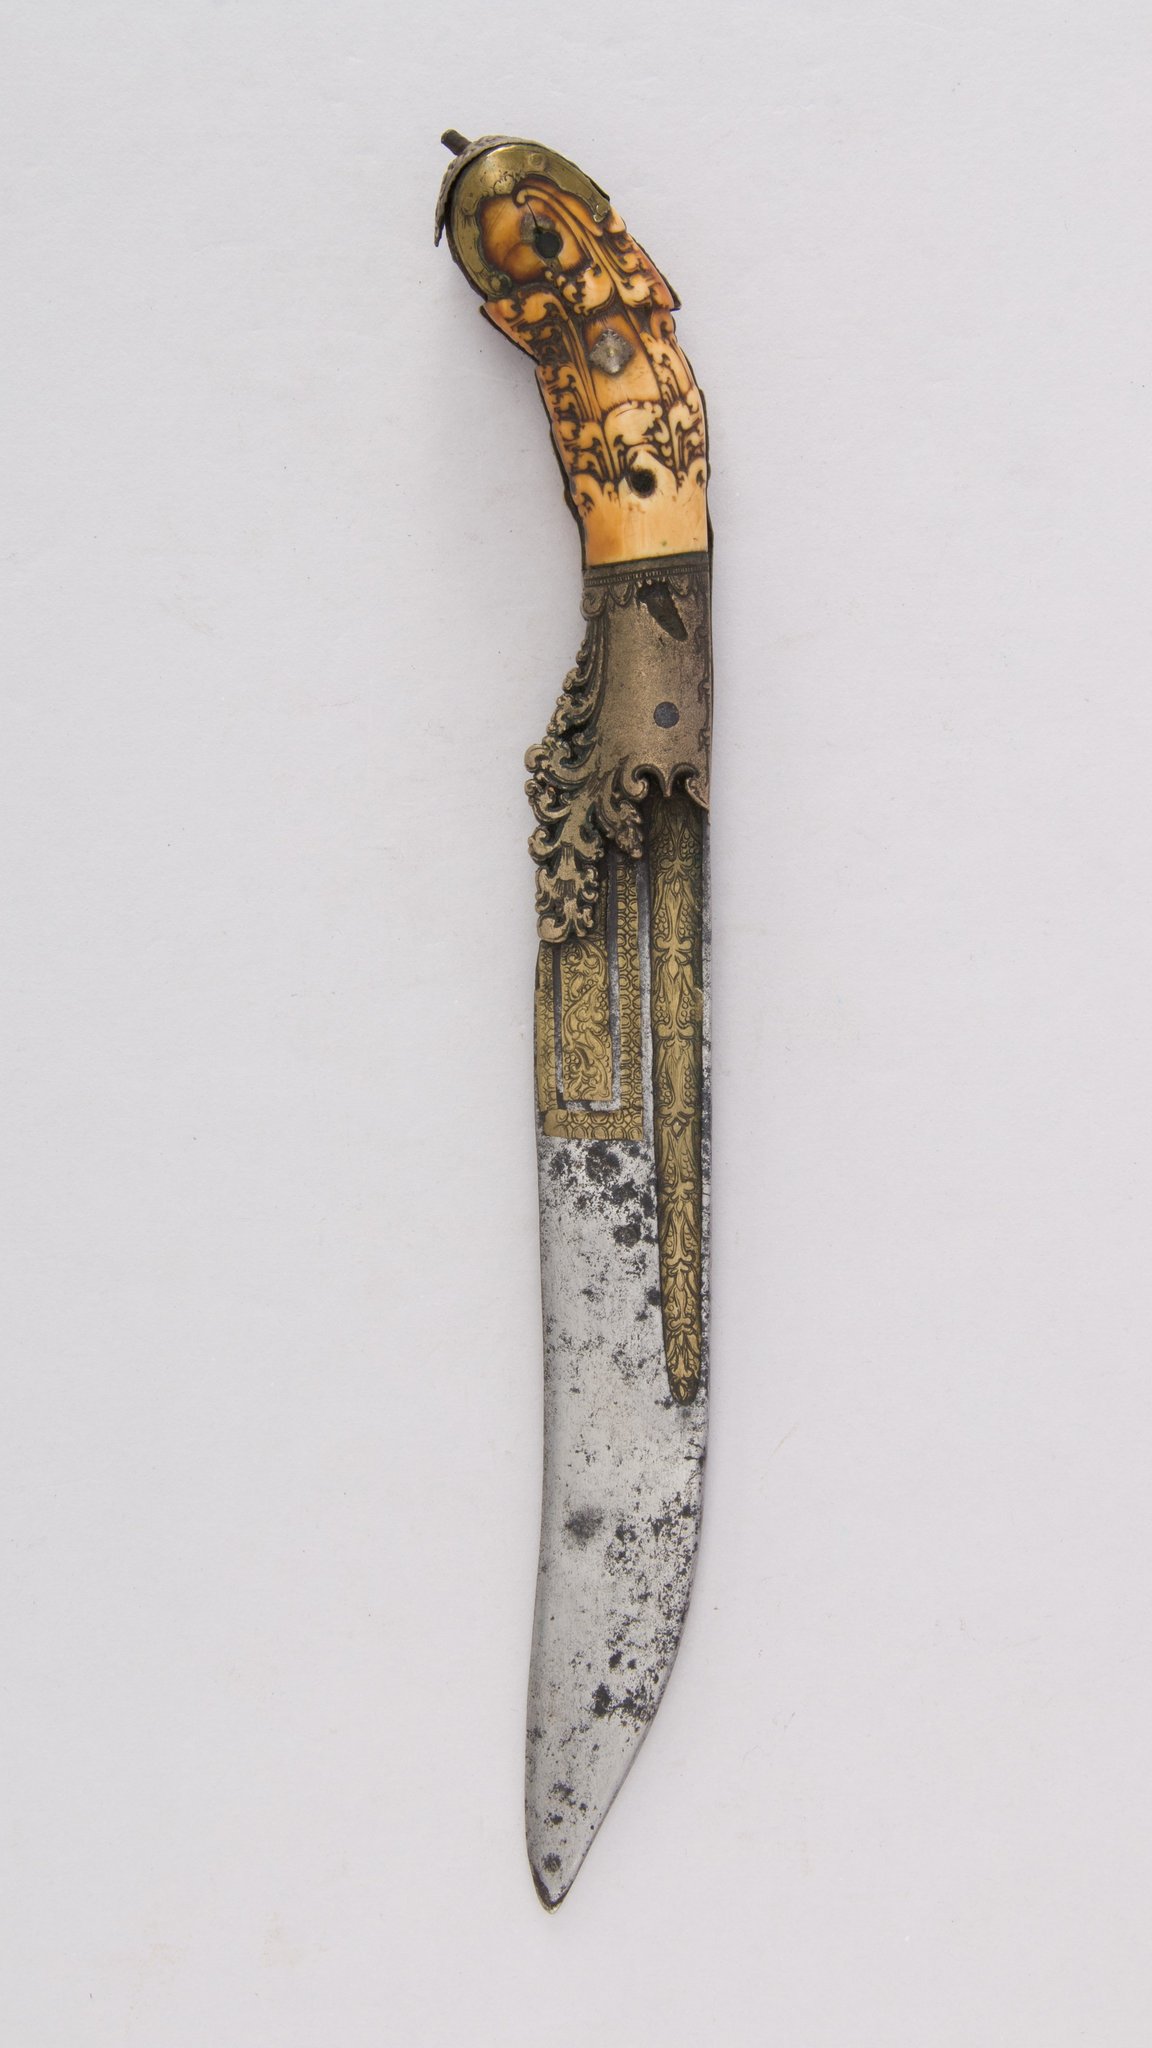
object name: dagger piha kaetta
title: Dagger (Piha Kaetta)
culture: sri lankan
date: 1701-1900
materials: brass, ivory, steel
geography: sri lanka